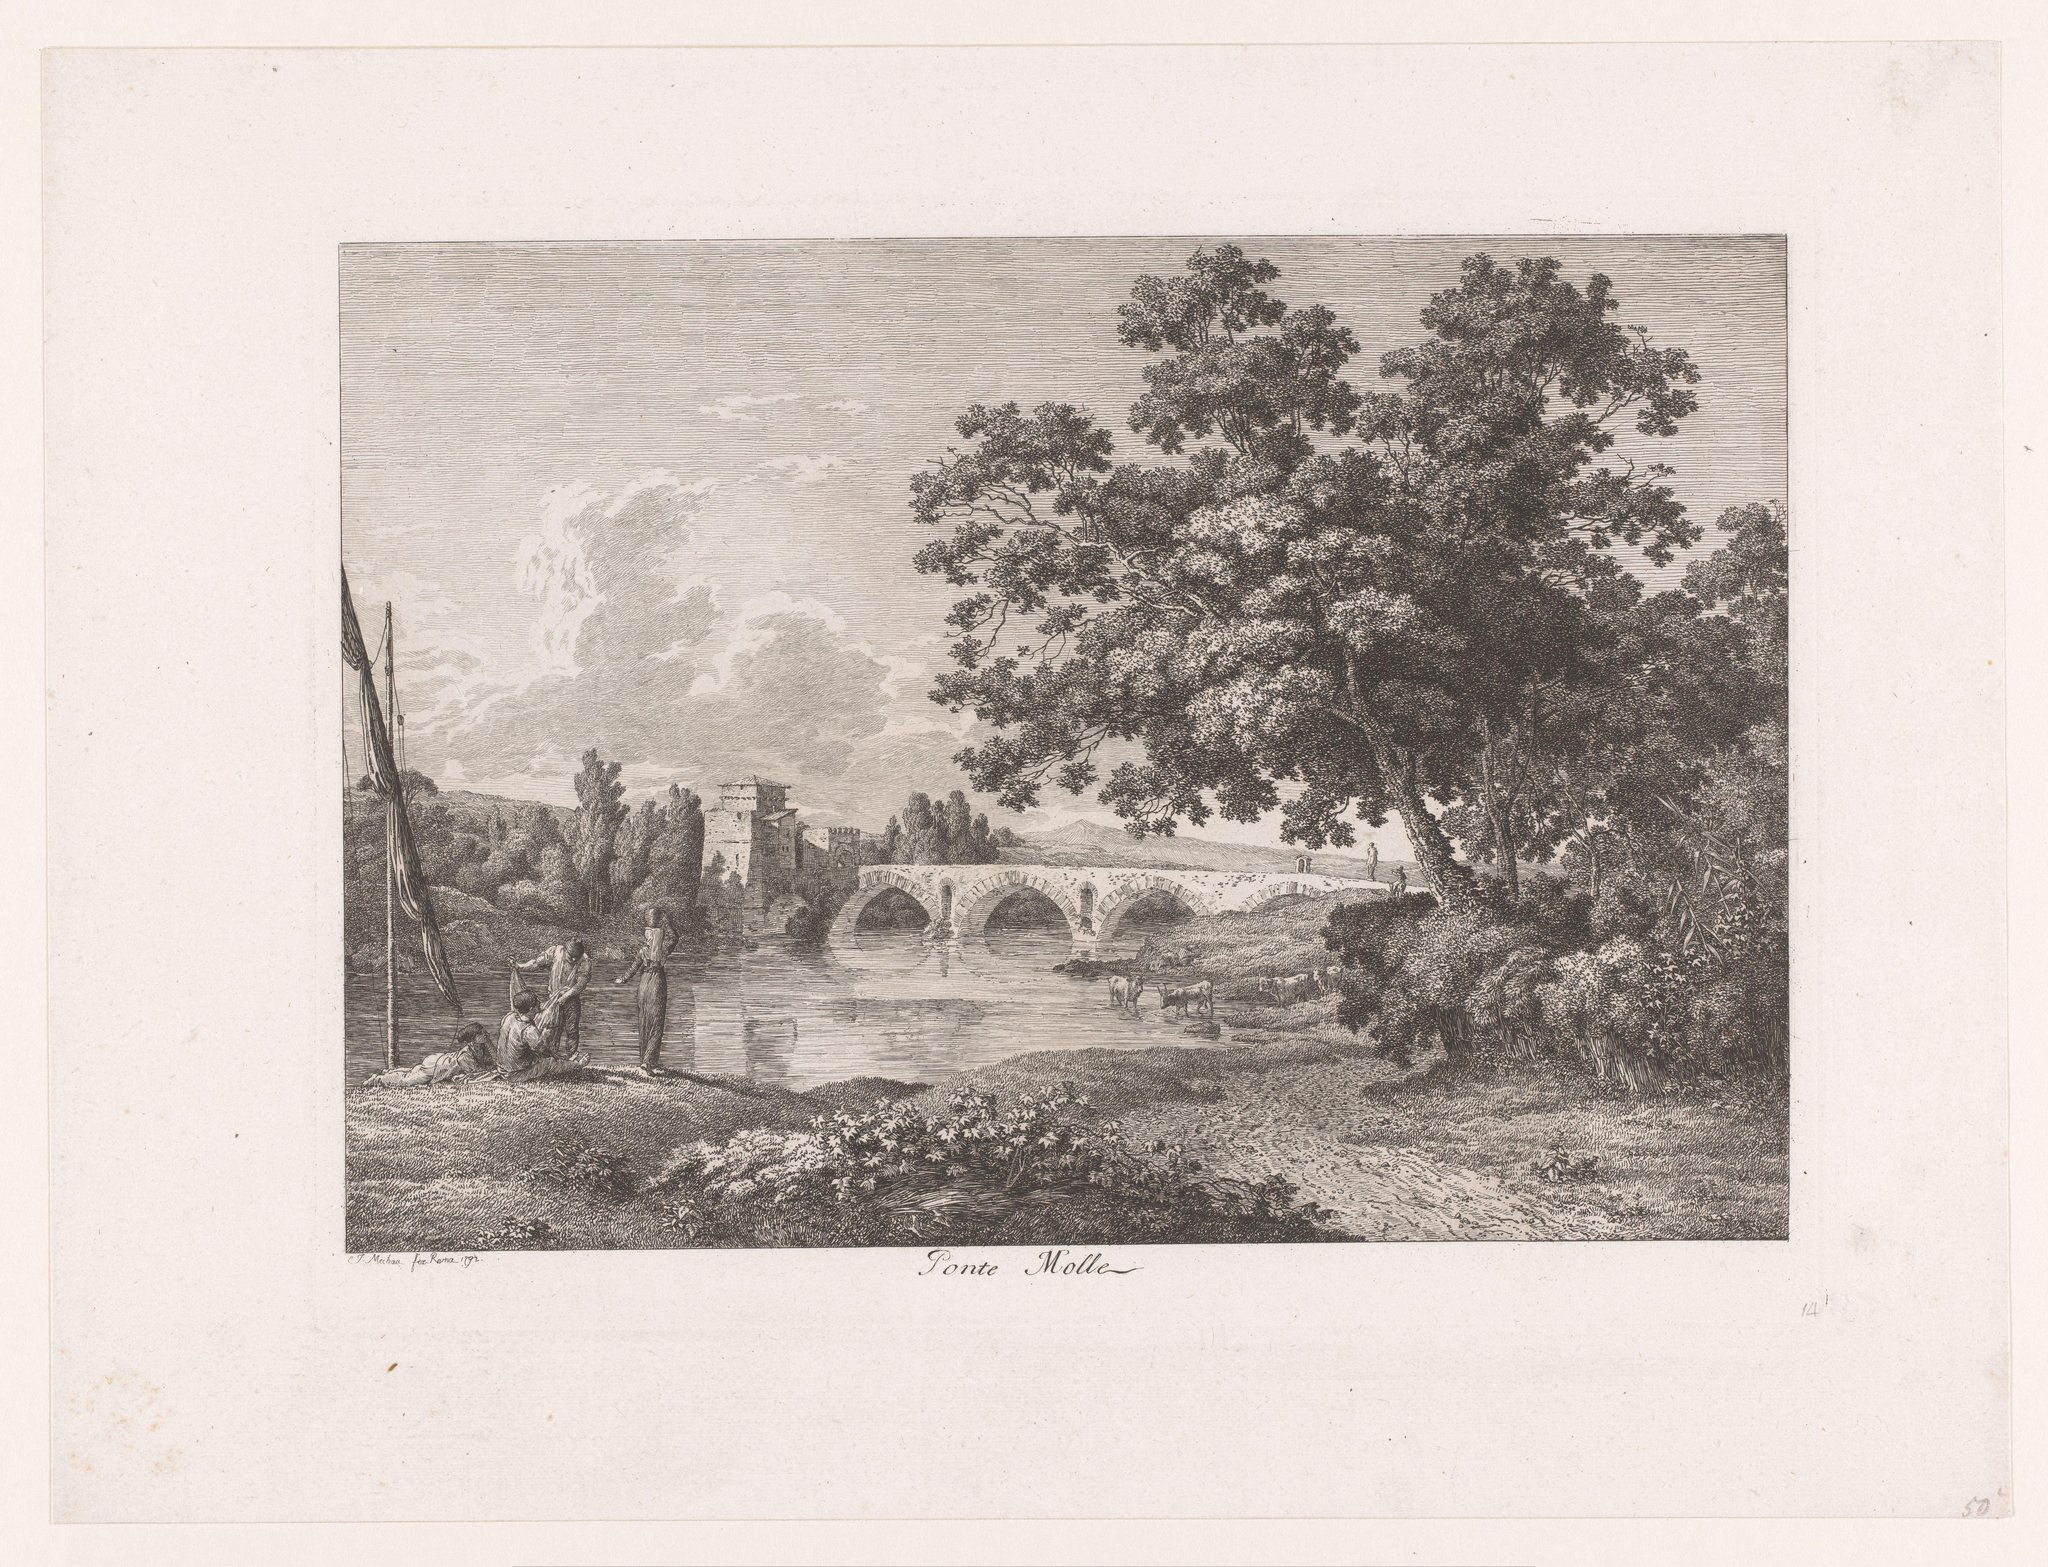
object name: print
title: Milvische brug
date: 1792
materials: paper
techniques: etching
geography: rome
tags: landscape with bridge, viaduct or aqueduct (+ city(-scape) with figures, staffage)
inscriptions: collector's mark: Lugt 2228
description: Behorend tot een set van 72 'Mahlerisch-radirte Prospecte von Italien', waarvoor de kunstenaar 24 prenten maakte. Albert Christoph Dies (1755-1822) en Johann Christian Reinhart (1761-1847) maakten eveneens 24 platen, in opdracht van Jean Fréderic Frauenholz.